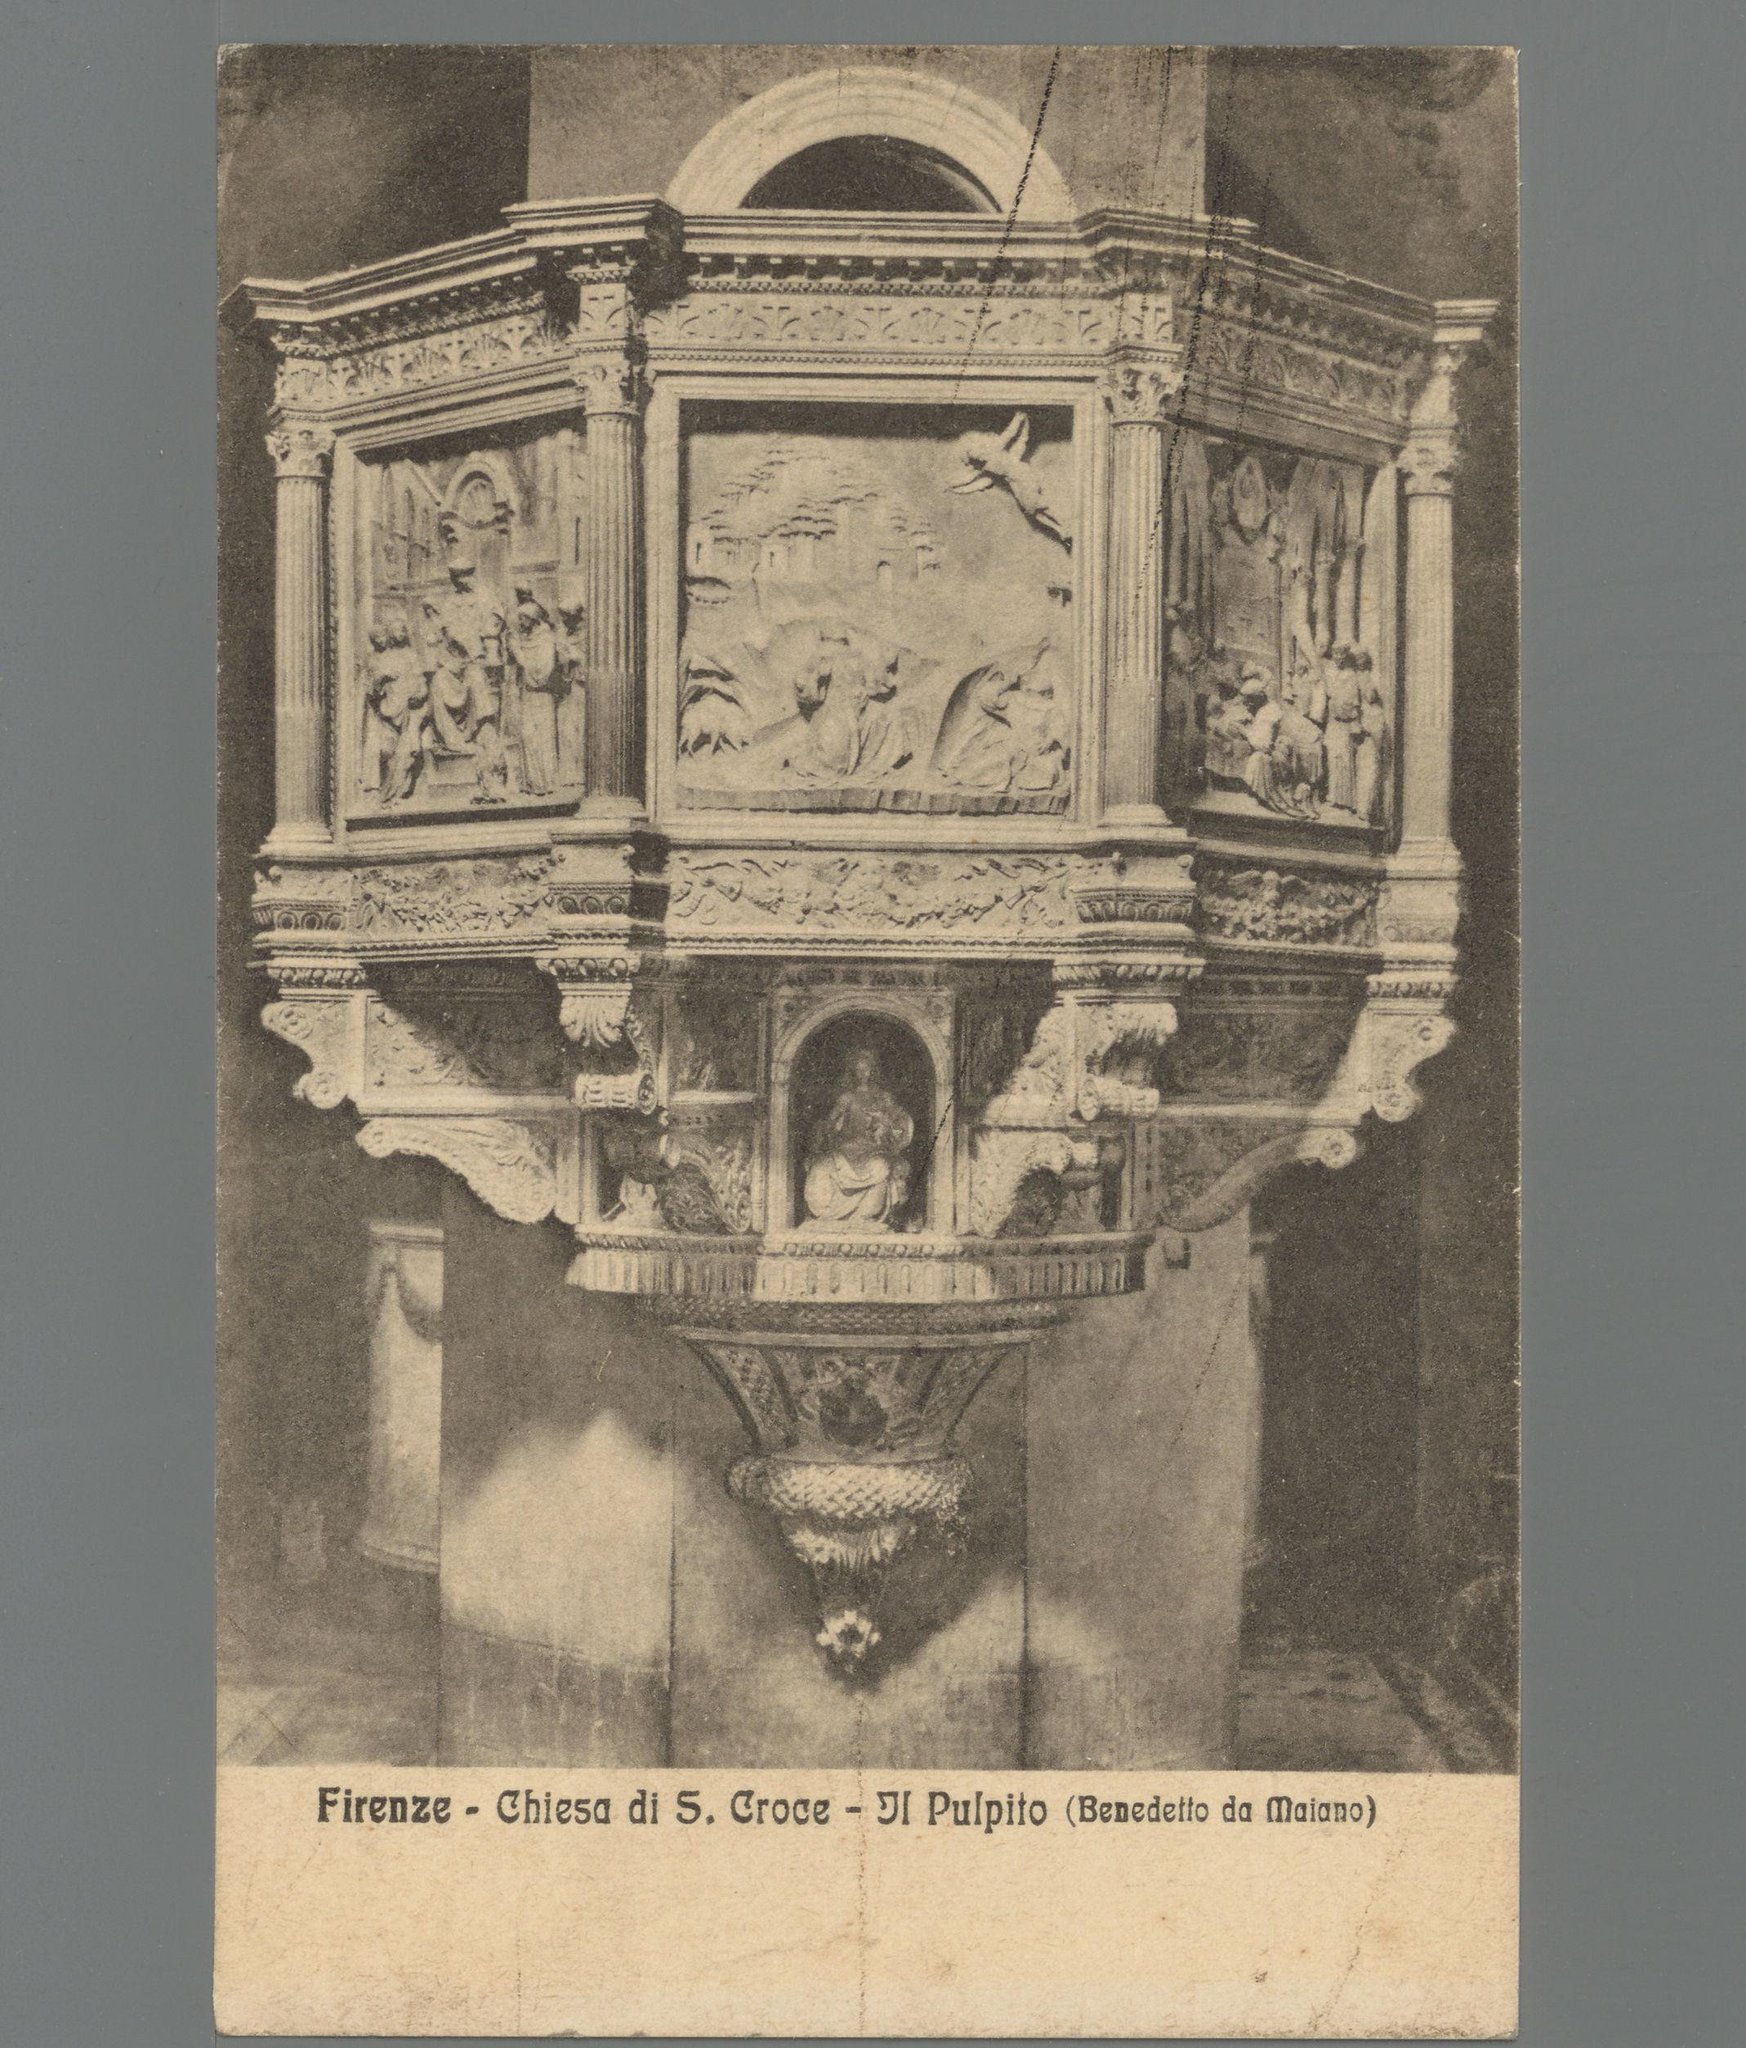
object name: ansichtkaart, prentbriefkaart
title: Firenze. Chiesa di S. Croce. Il Pulpito (Benedetto da Maiano)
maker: Anonymous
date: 1910-1929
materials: cardboard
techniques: photograph, writing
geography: terni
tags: pulpit, ambo, chancel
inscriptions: postage stamp